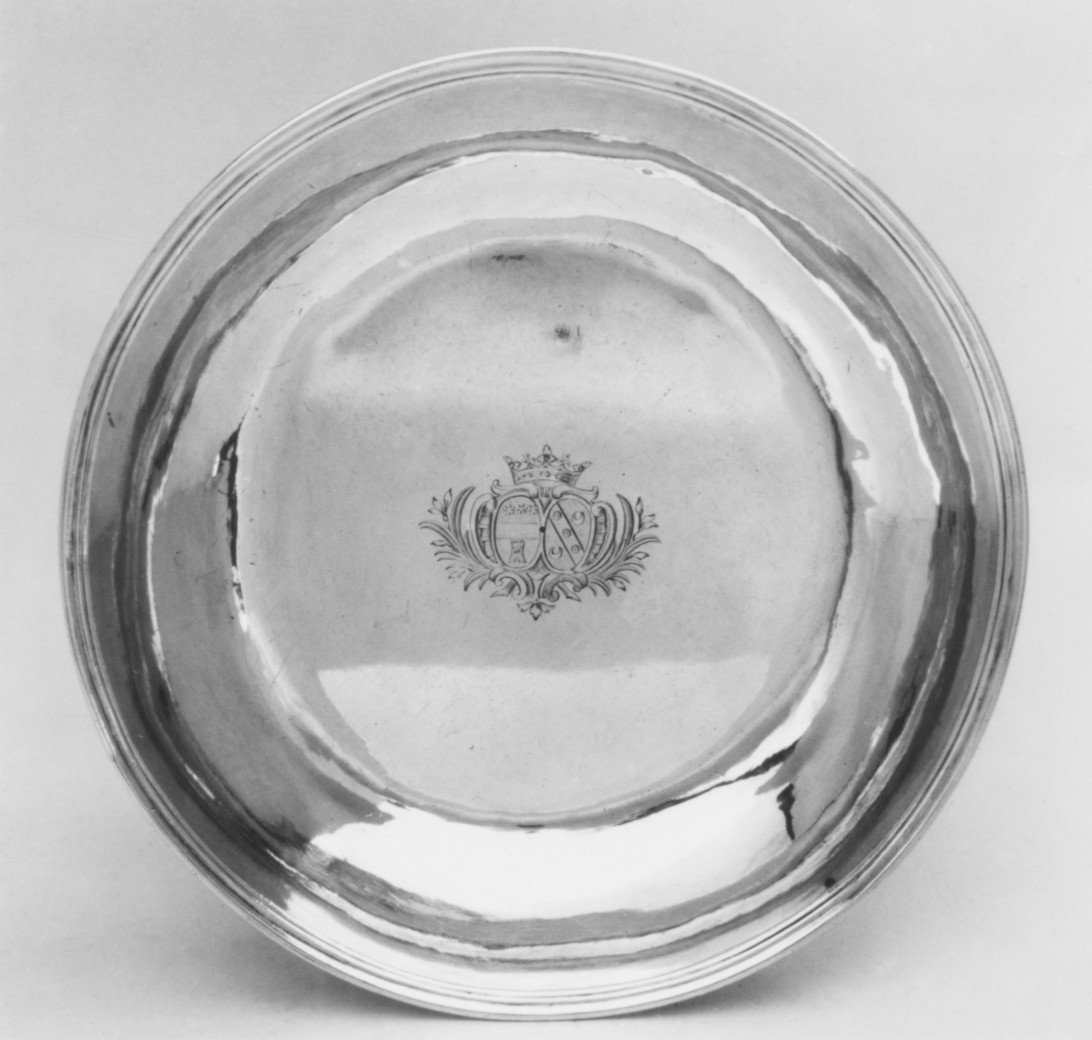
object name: dish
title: Dish (one of a pair)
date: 1697-1704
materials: silver